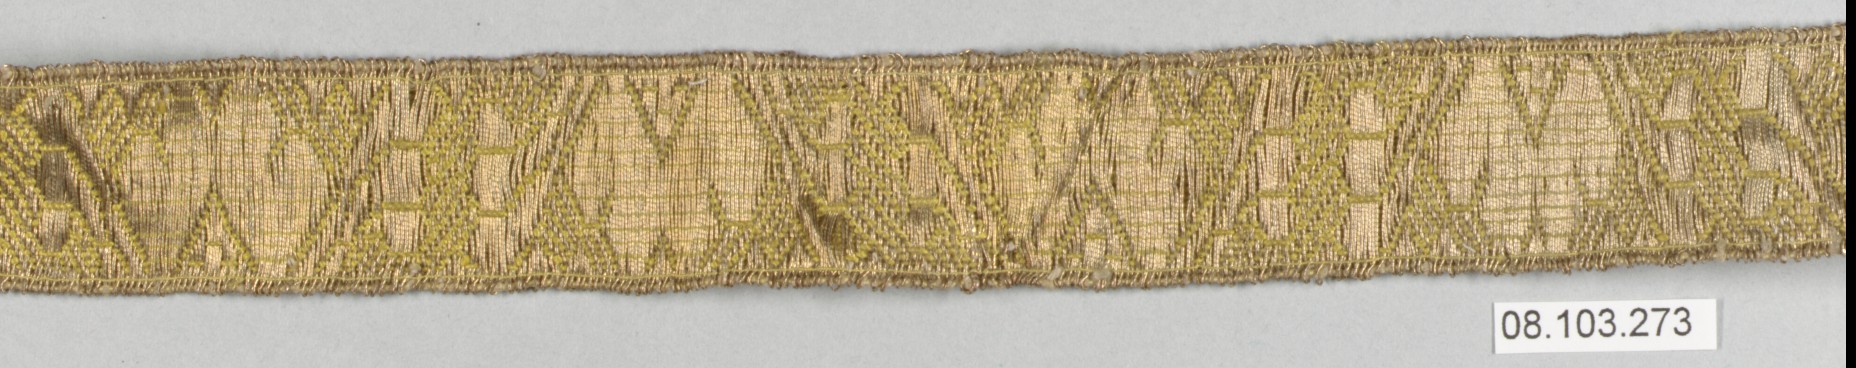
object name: galloon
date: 1601-1800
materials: metal thread, silk